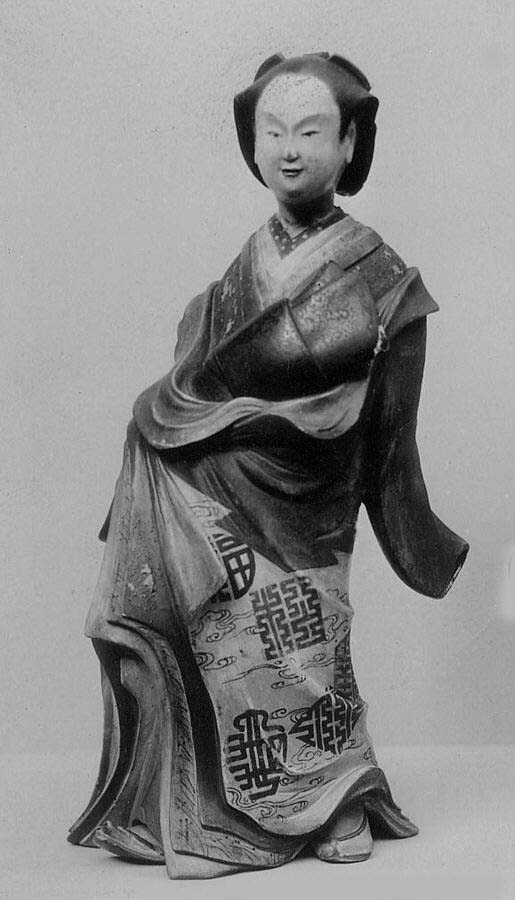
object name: alcove ornament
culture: japanese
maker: kimura sakujiro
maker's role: artist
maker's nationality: japanese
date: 1780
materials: enamel, faience, pottery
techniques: polychrome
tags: women